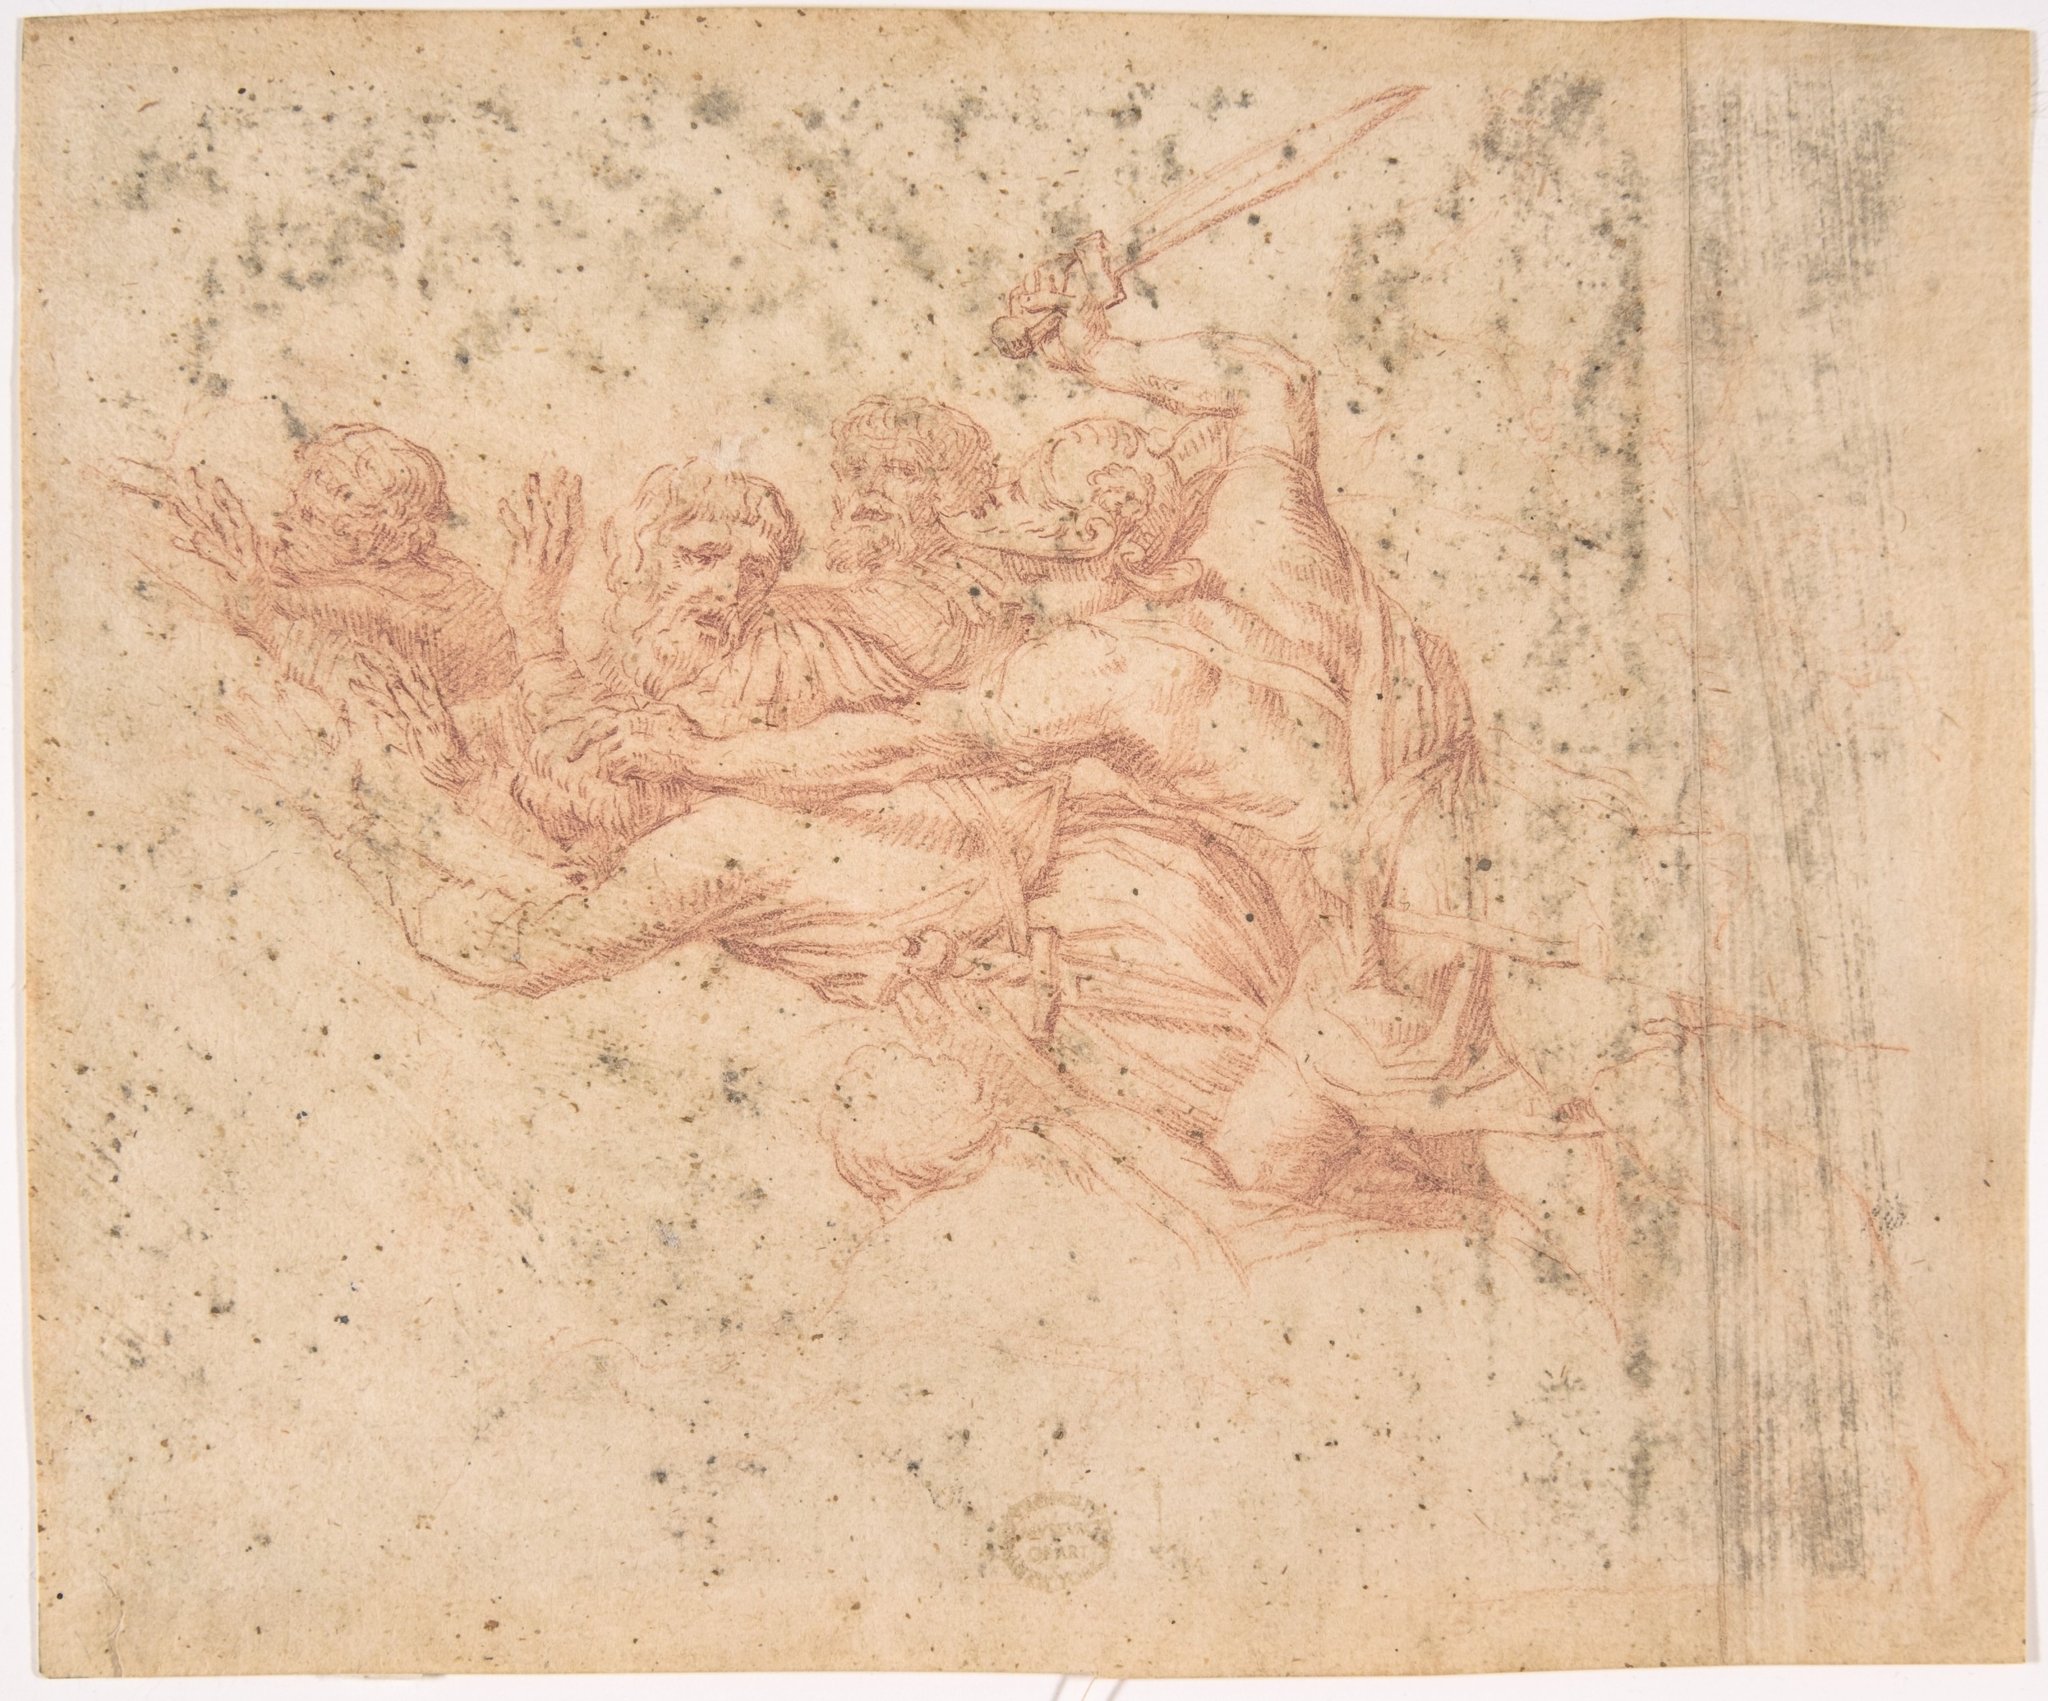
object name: drawing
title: Battle Scene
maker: anonymous, italian, 16th century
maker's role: artist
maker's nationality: italian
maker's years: 1500-1600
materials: chalk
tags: battles,swords,men